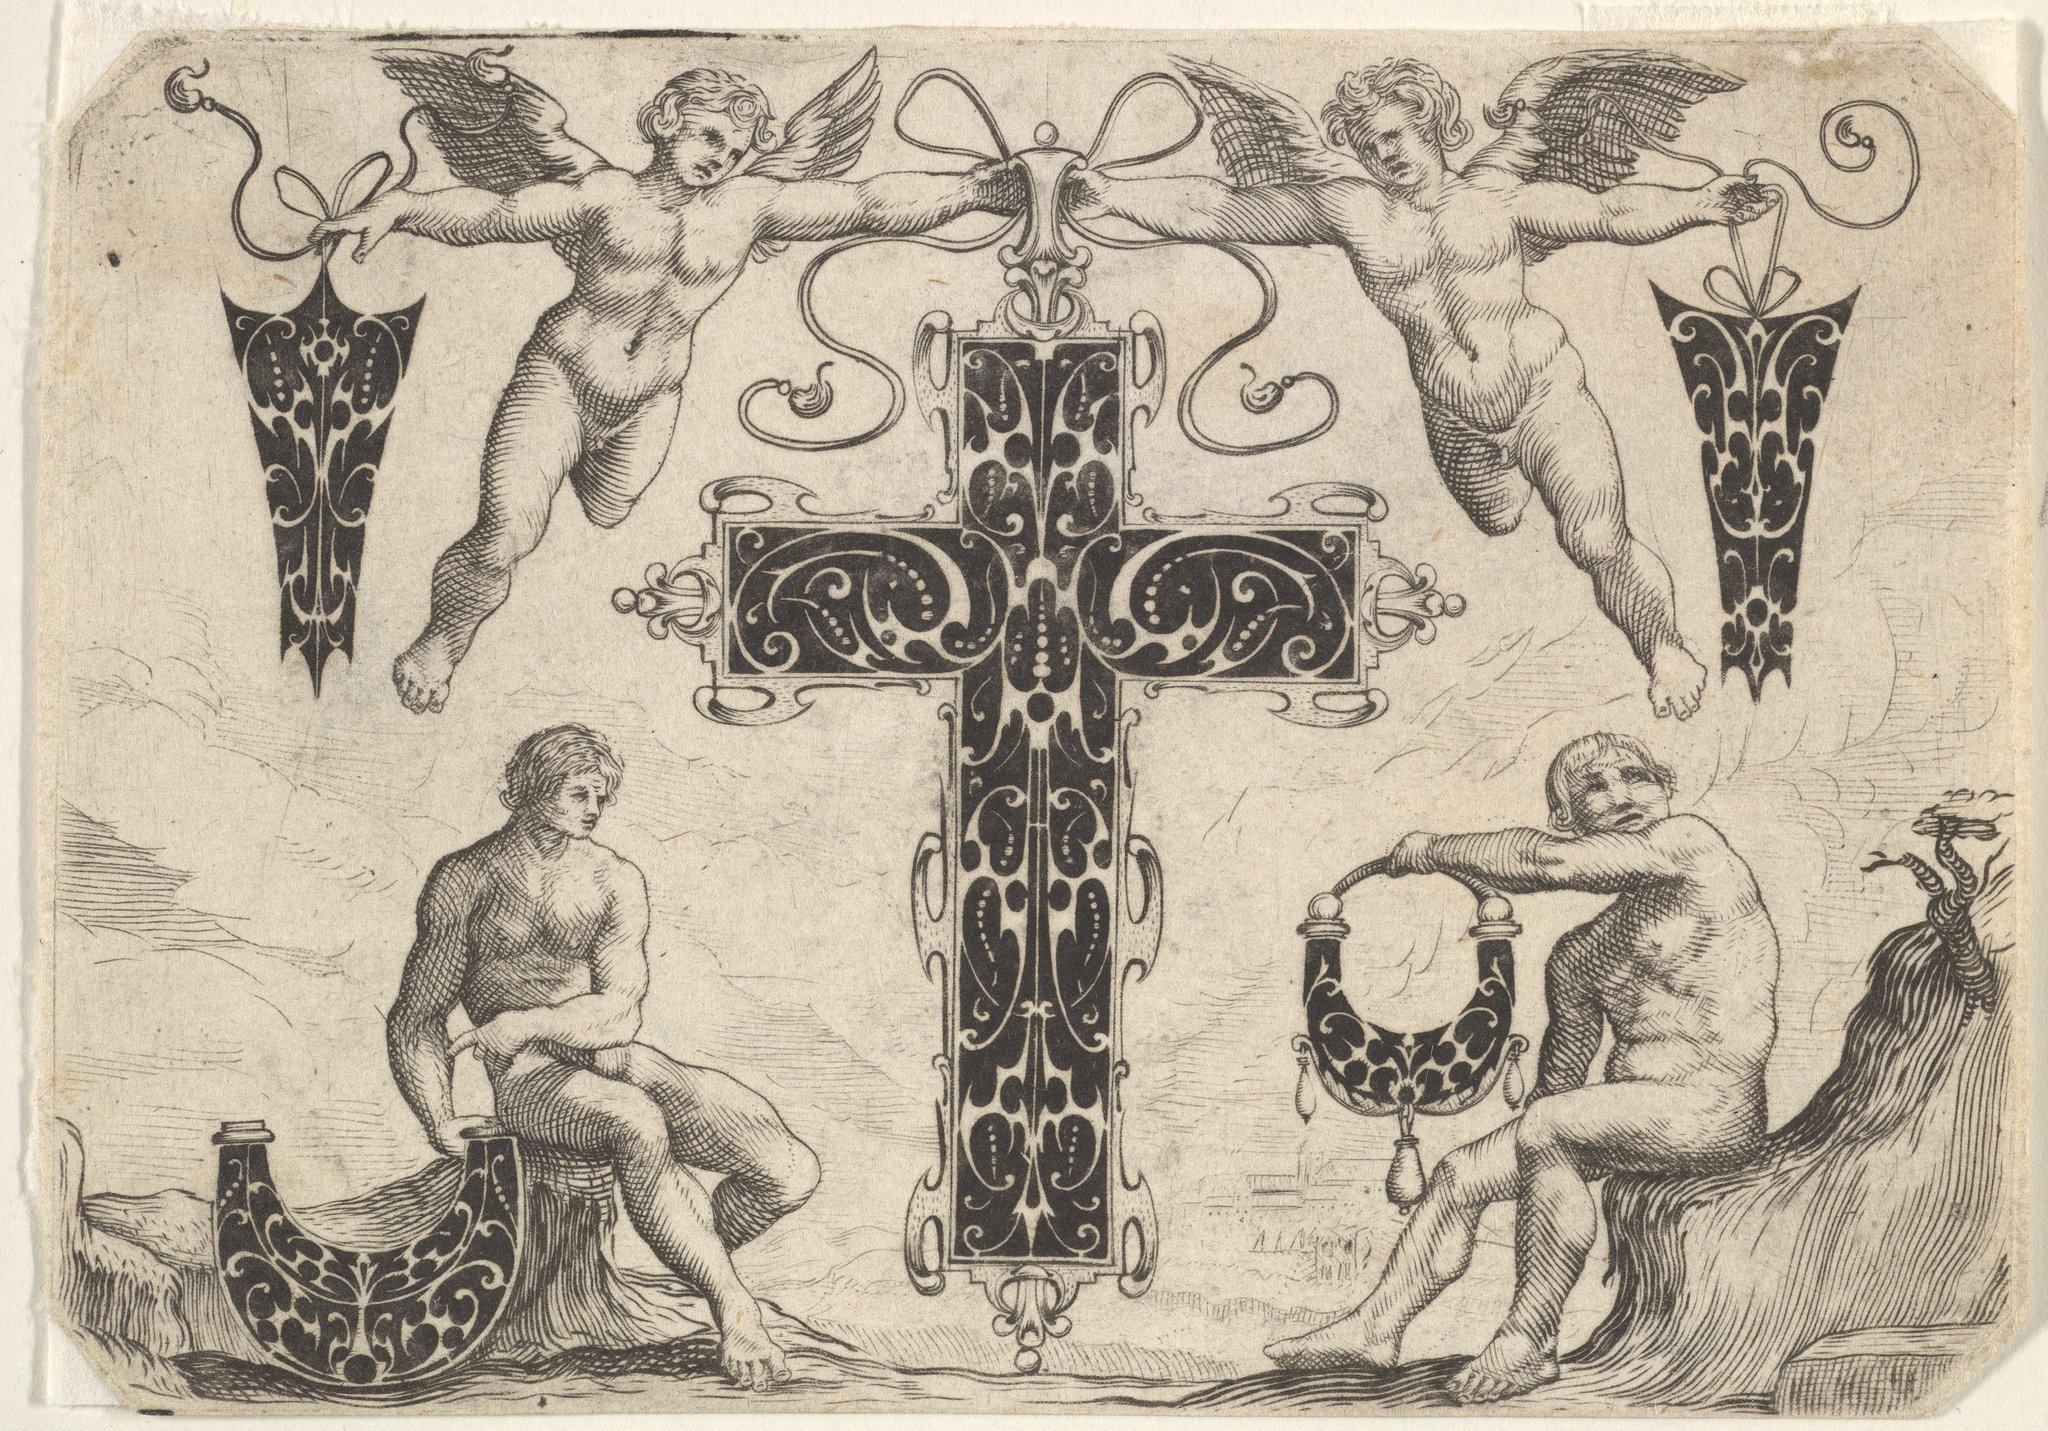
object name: print collection ornament architecture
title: Cross-shaped Pendant and Four Other Motifs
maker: giovanni battista costantini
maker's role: printmaker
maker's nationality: italian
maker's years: 1615-1628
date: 1622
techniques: embroidery, engraving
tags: pendants,male nudes,cupid,cross